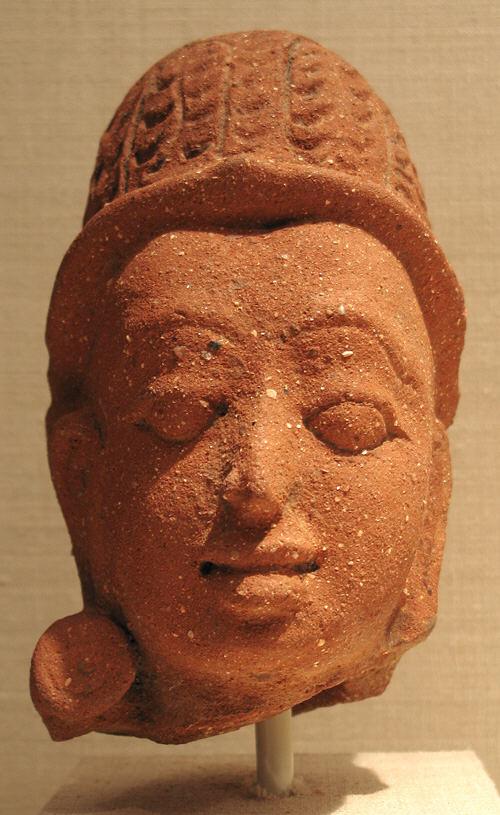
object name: head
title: Head of a Deity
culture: sri lankan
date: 401-600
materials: terracotta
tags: heads